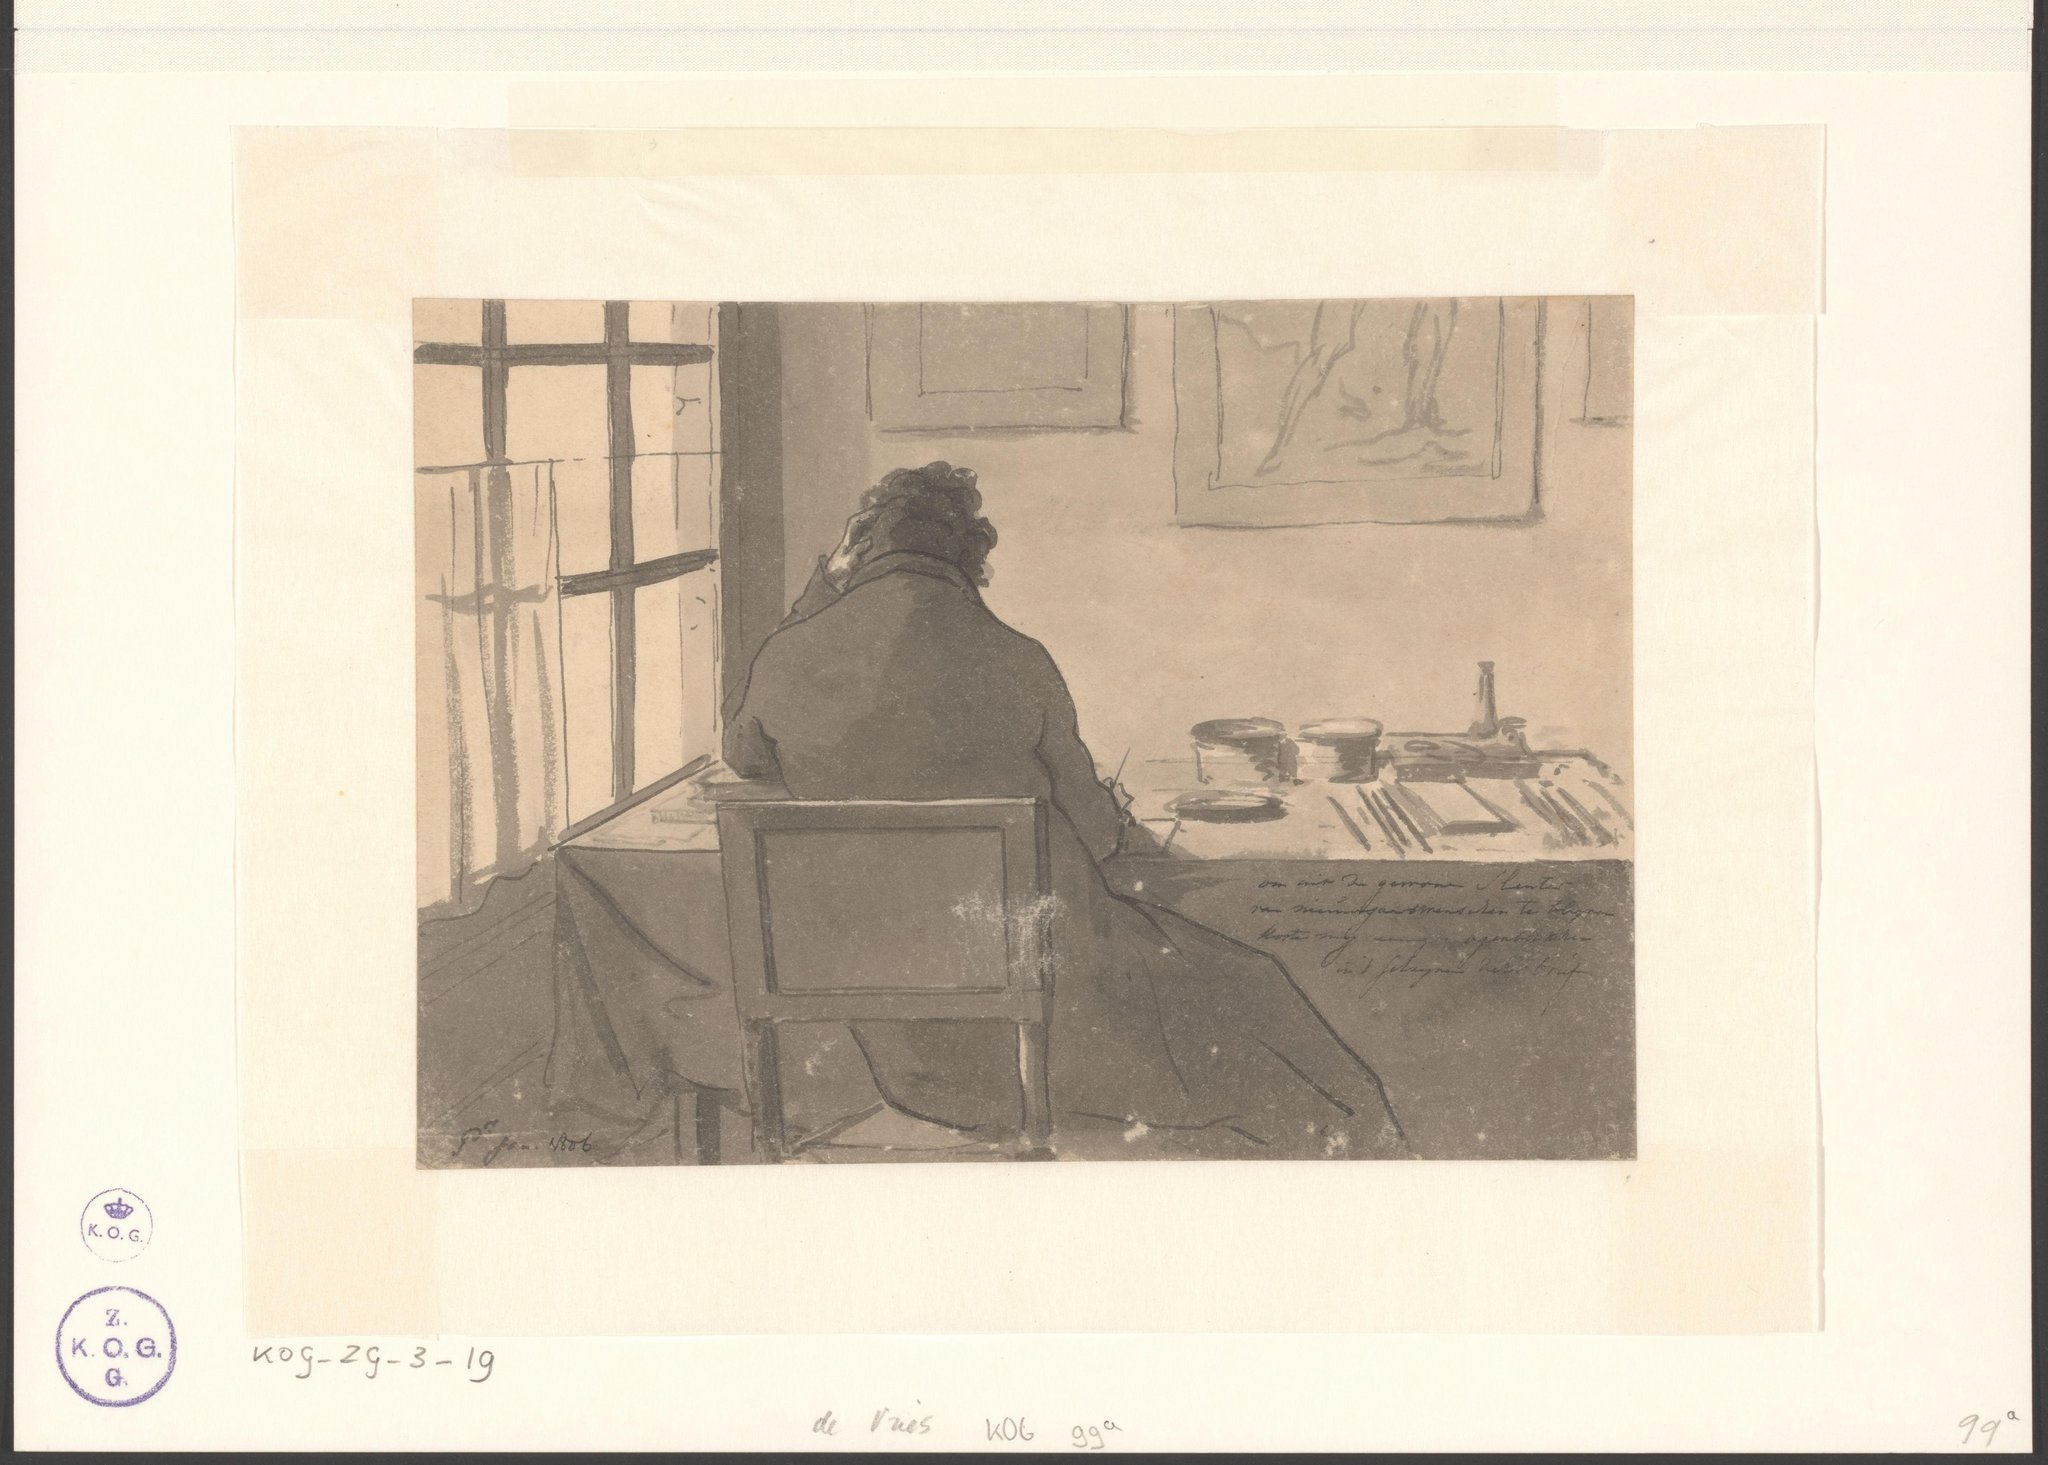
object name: drawing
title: Christiaan Andriessen tekenend aan tafel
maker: christiaan andriessen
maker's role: draughtsman, print maker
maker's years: 1775-1846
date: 1805-1808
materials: ink, paper, pencil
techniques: brush, pen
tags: picture, painting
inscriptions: collector's mark: Lugt 1641a, inscription: ‘J Andriessen’, inscription: ‘Om uit den gewonen slenter der nieuwjaarsbrieven te blijven kostte mij eenige oogenblikken (...)’, collector's mark: Lugt 1641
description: Dagboekblad uit het getekende dagboek dat Christiaan Andriessen bijhield van 1805 tot en met 1808.